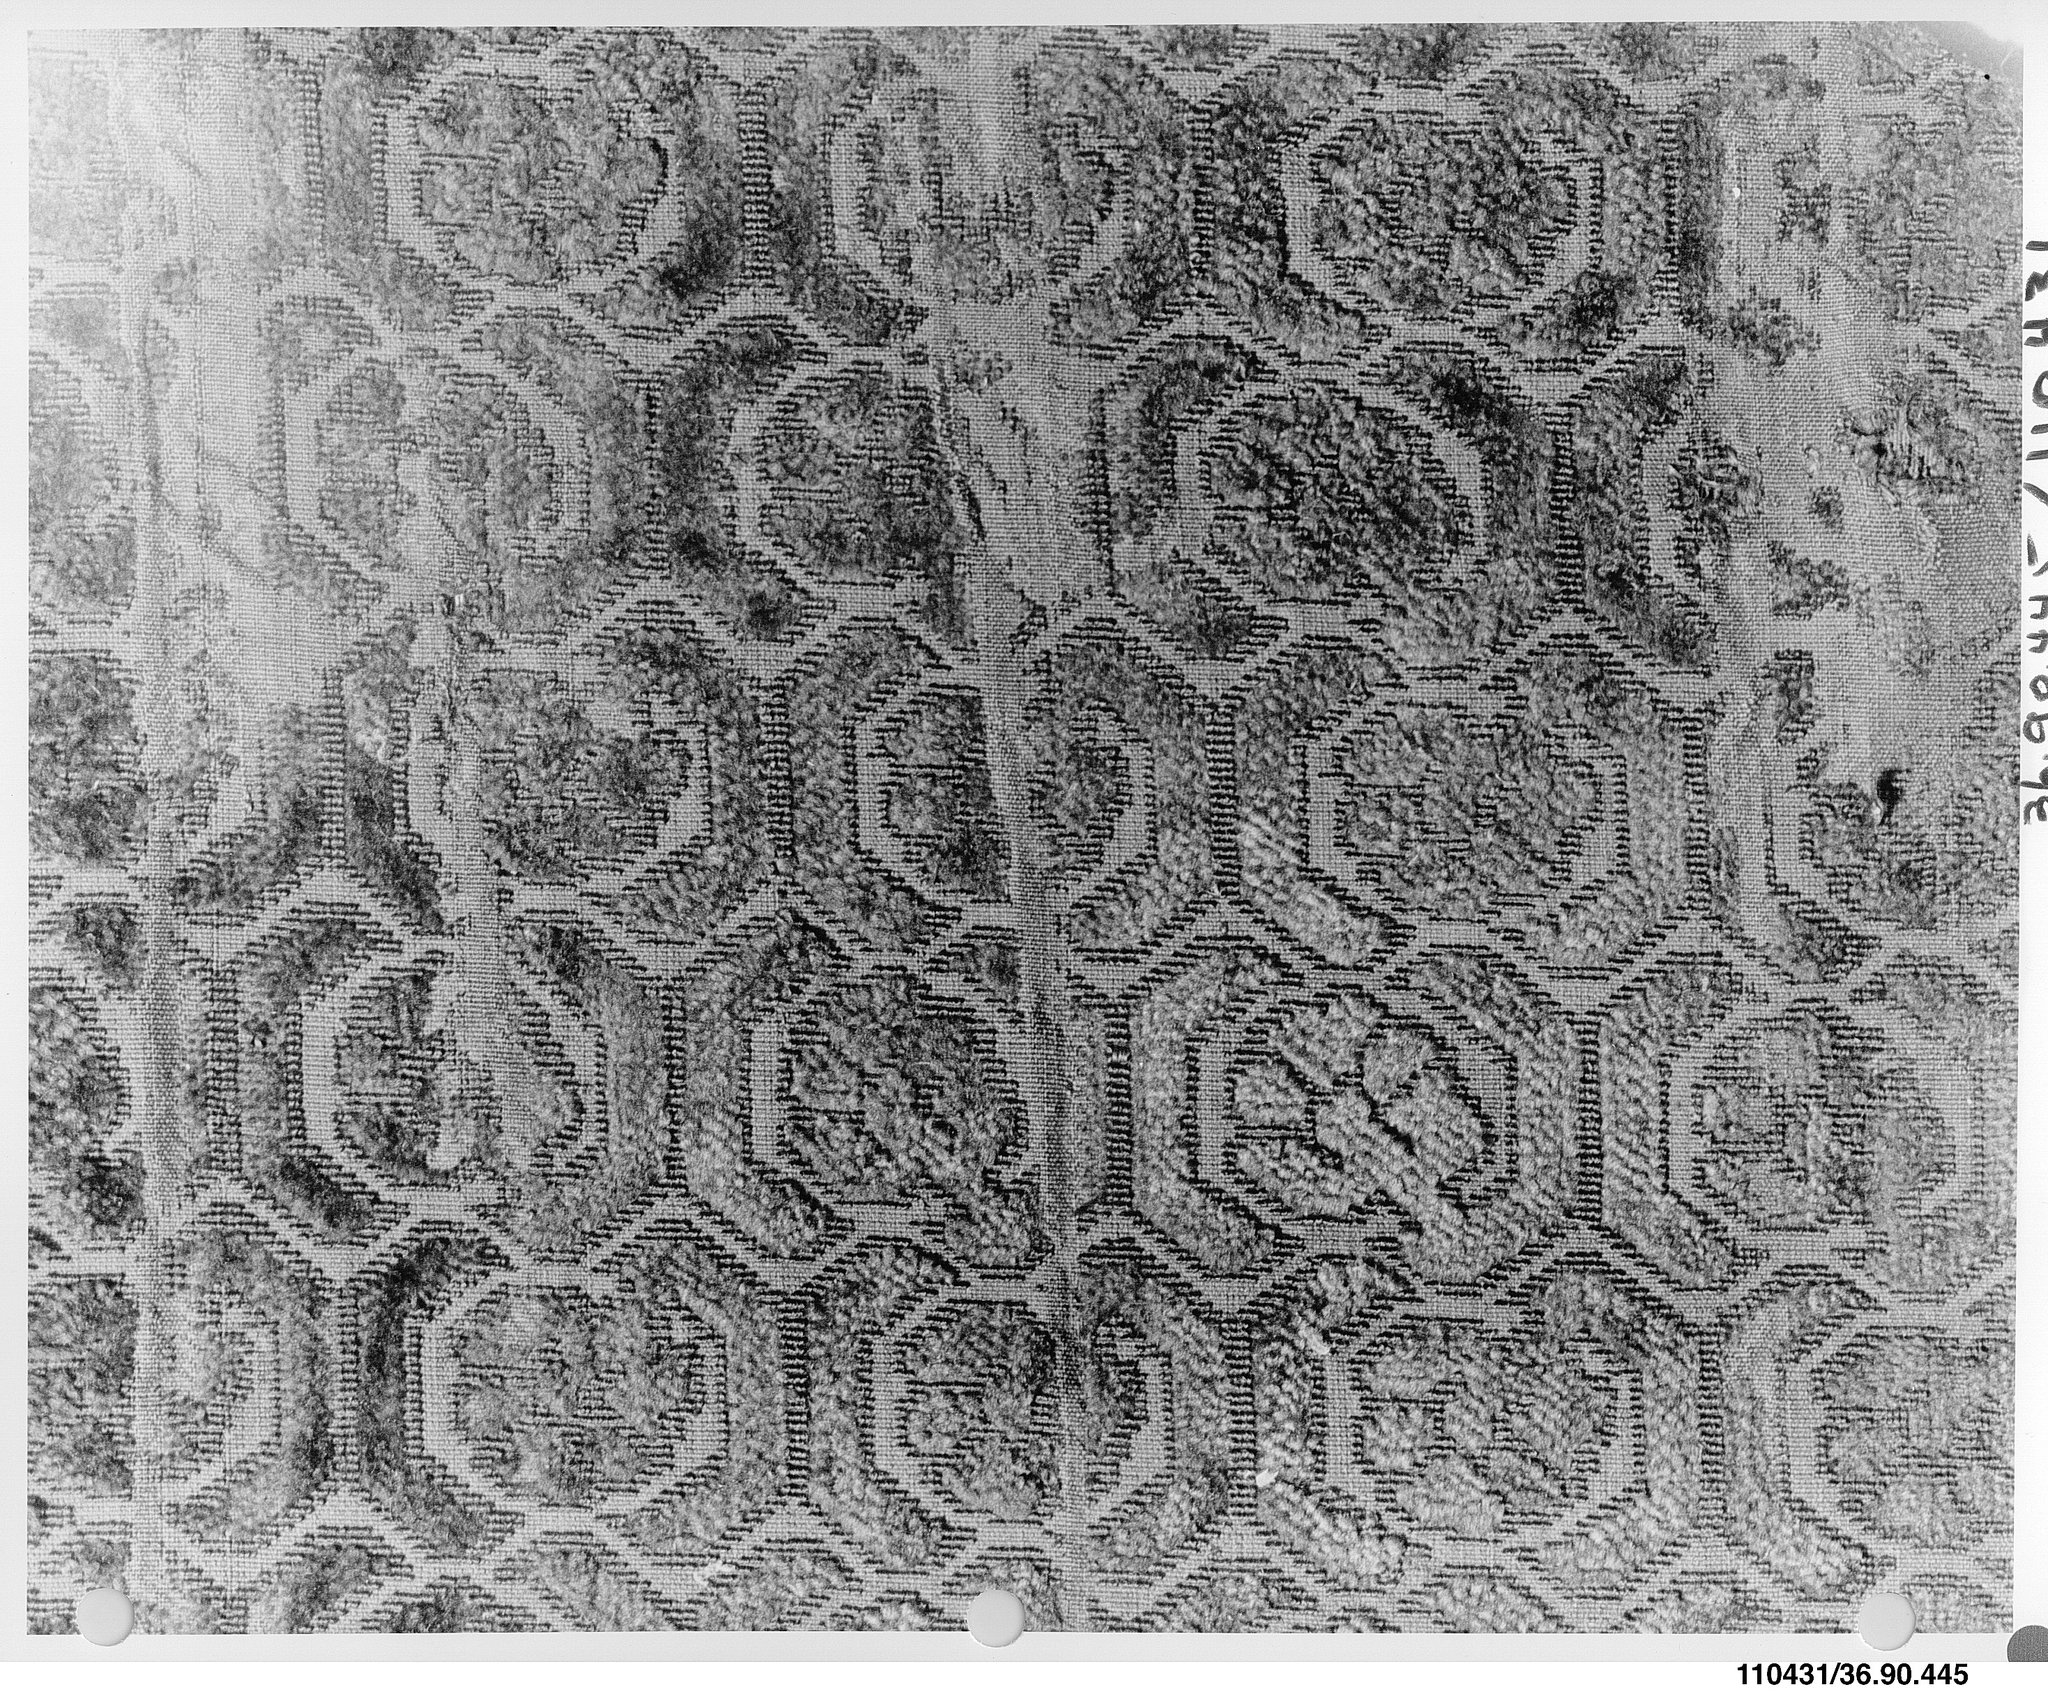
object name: piece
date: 1501-1700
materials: silk